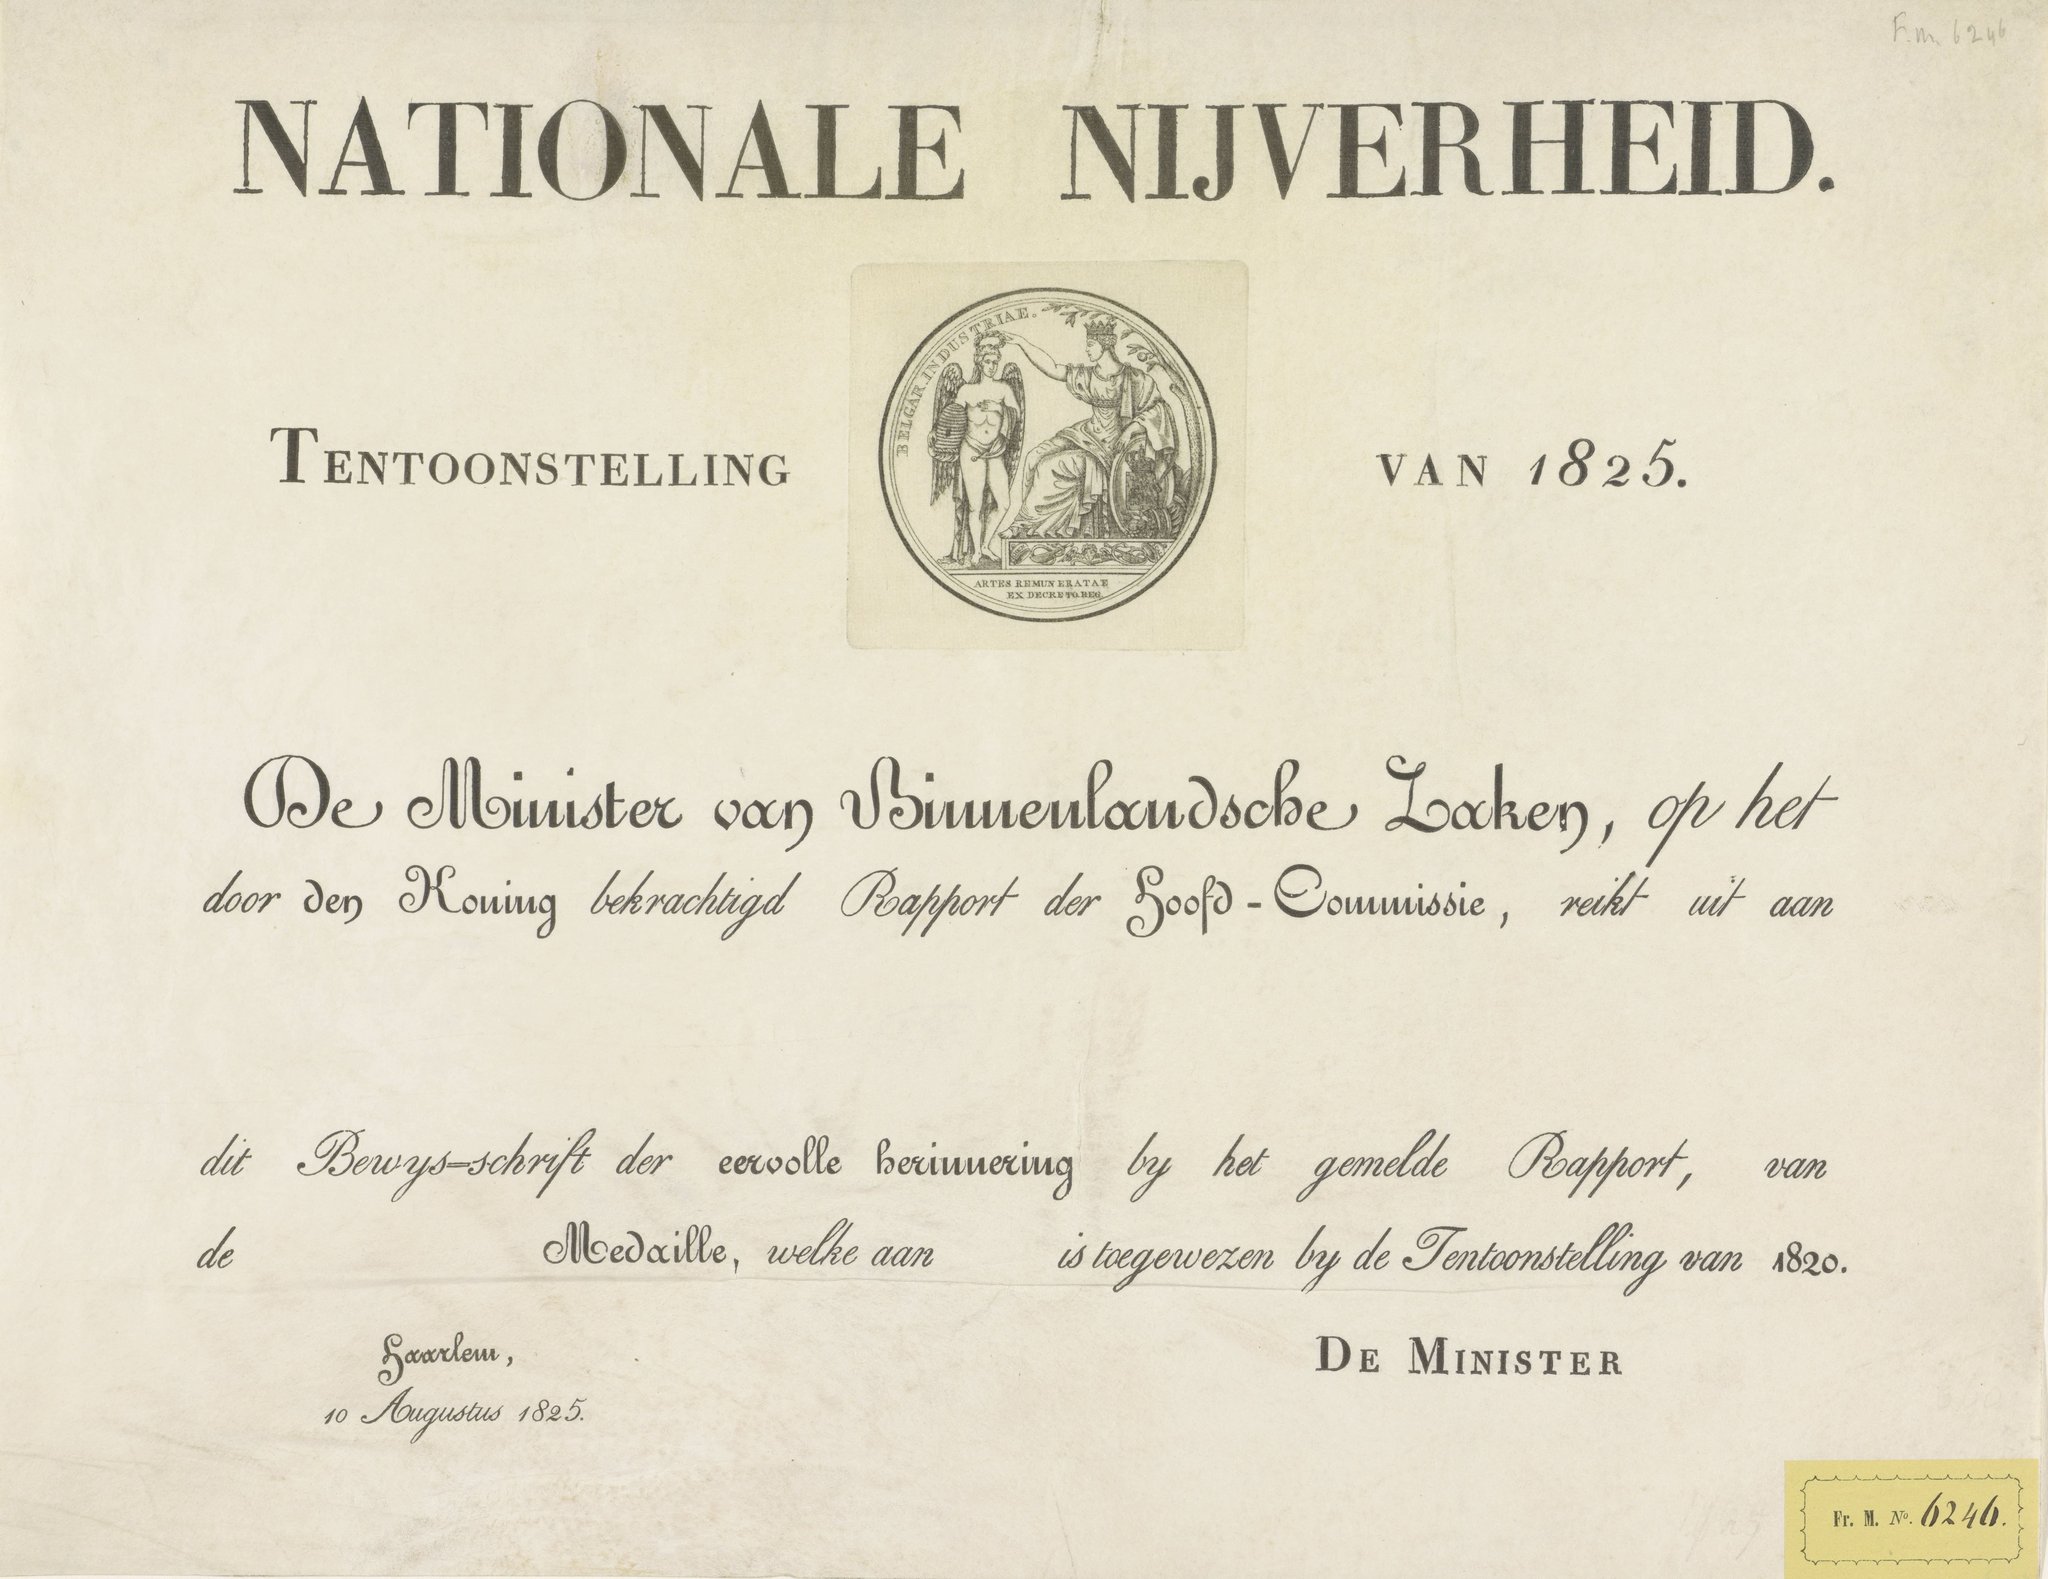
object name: print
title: Diploma van de Tentoonstelling Nationale Nijverheid, 1825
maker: Anonymous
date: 1825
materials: parchment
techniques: engraving, etching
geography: netherlands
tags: personifications of countries, nations, states, districts, etc., distribution of awards ~ art contest, industriousness, assiduity; 'assiduità', 'industria', 'zelo' (ripa), medal (considered as a piece of sculpture, regardless of its specific function), haarlem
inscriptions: collector's mark: Lugt 2228, label: ‘Fr. M. No. 6246’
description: Diploma bestemd om uit te reiken op de Tentoonstelling Nationale Nijverheid in Haarlem, augustus 1825. Oningevuld exemplaar met een voorgedrukte tekst en een afbeelding van de allegorische voorstelling op de medaille als prijspenning uitgereikt op de tentoonstelling. Op de medaille kroont de Nederlandse Maagd de Nijverheid.